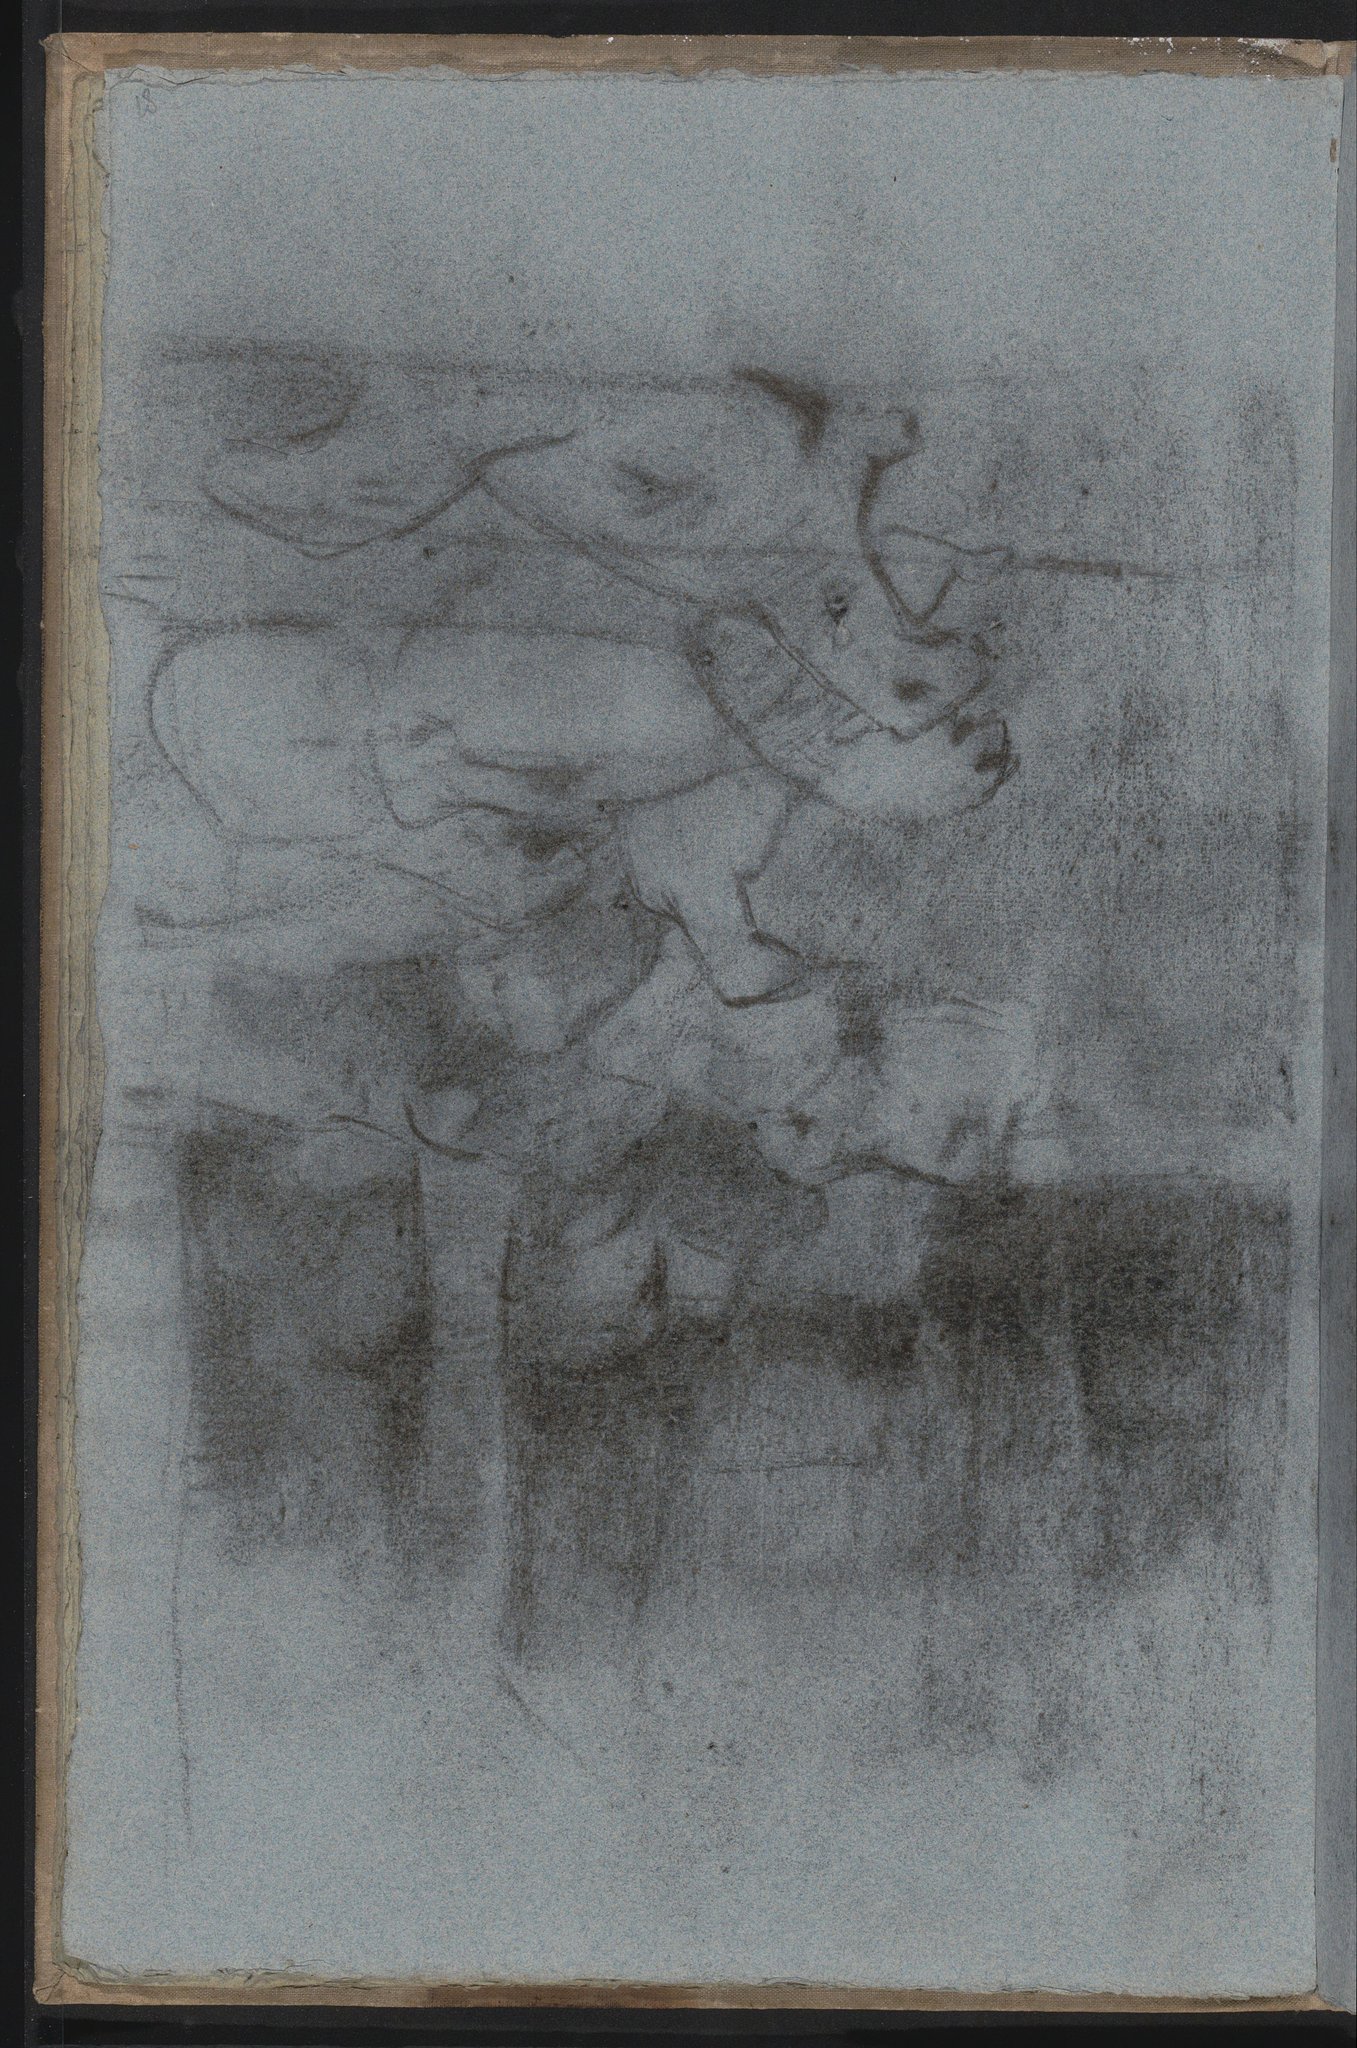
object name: sketchbook leaf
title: Liggende schapen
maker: willem witsen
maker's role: draughtsman, painter, print maker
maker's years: 1860-1923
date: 1884-1887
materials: chalk, paper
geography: ewijkshoeve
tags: sheep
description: Pagina 18 uit een schetsboek met 45 bladen vervaardigd rond de Ewijkshoeve.